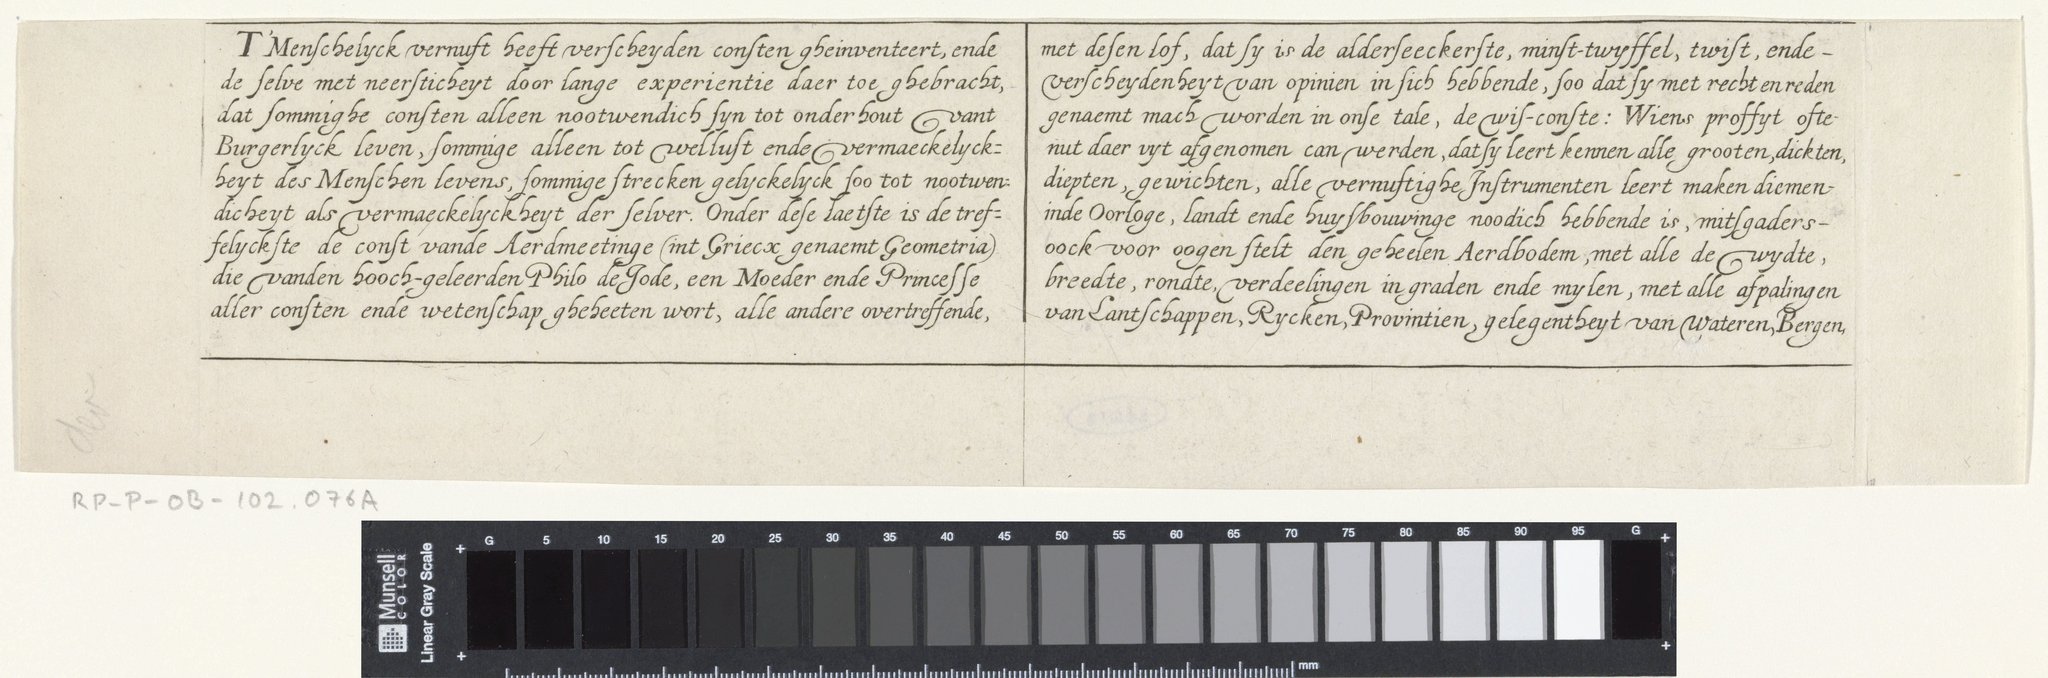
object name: map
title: Kaart van Delfland (tekstblad linksonder)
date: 1612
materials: paper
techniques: engraving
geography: delft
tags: delfland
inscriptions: collector's mark: Lugt 2228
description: Kaart van Delfland. Boven in het midden het wapen van het Hoogheemraadschap Delfland en de gemeentewapens van de steden. Linksonder een windroos. Geheel bestaande uit negen bladen en zes tekstbladen: tekstblad linksonder.